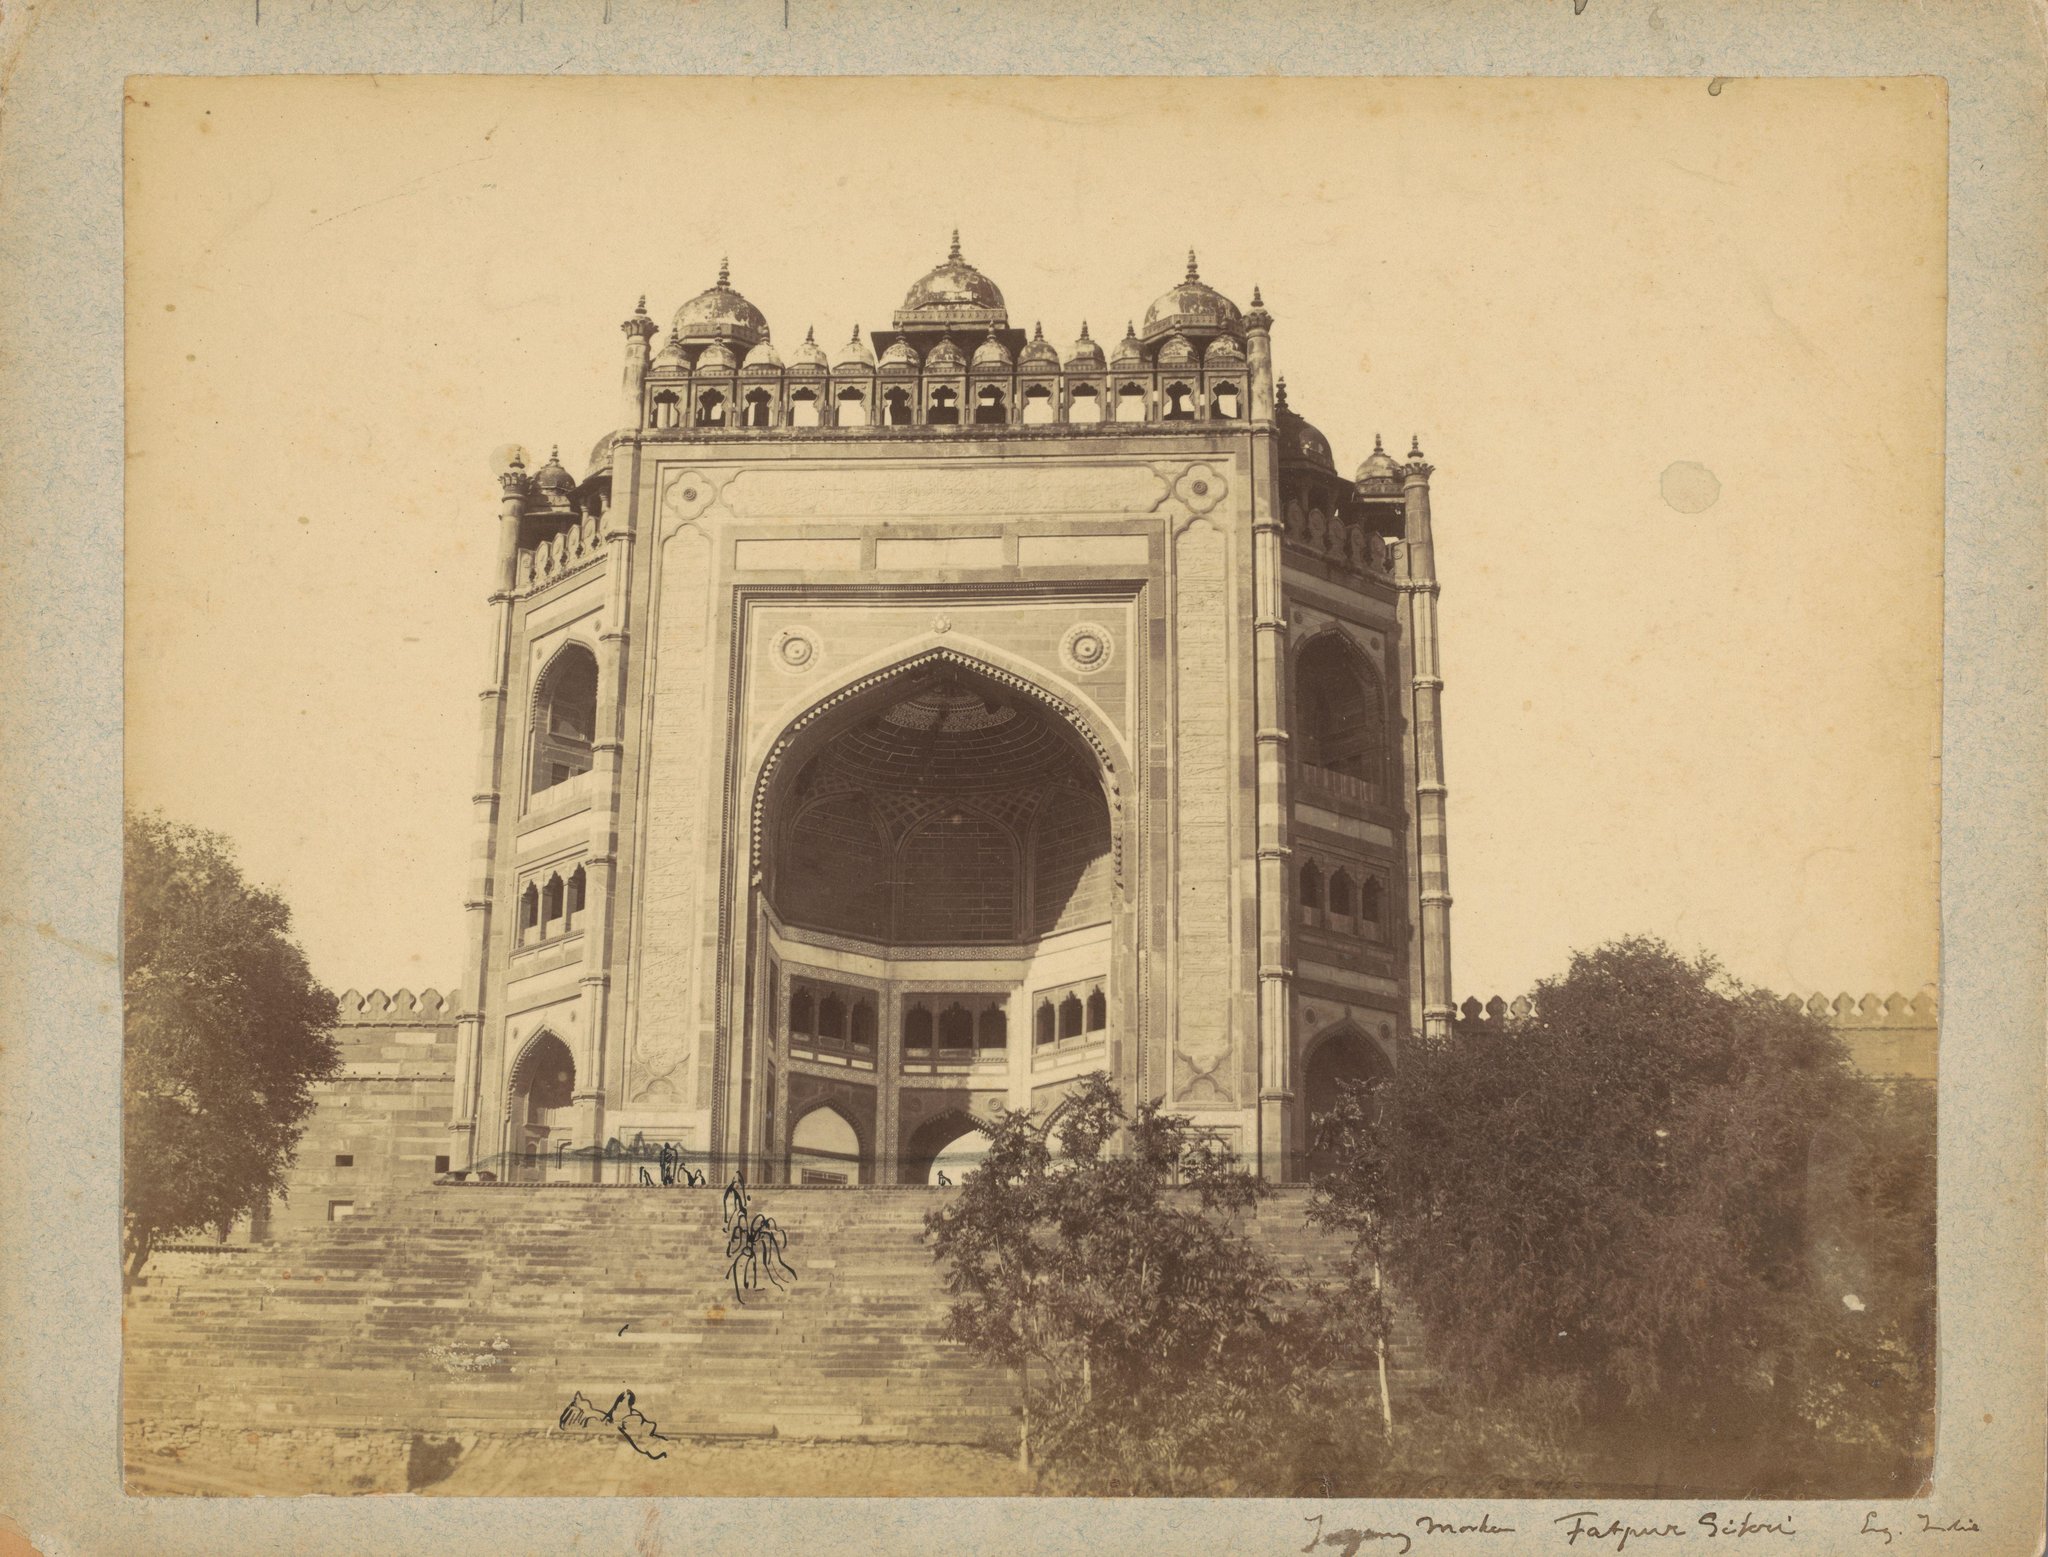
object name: photograph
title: Buland Darwaza, Fatehpur Sikri, Uttar Pradesh, India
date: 1870-1890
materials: cardboard, ink, pencil, photographic support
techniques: albumen print, pen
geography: fatehpur sikri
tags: temple, shrine ~ islam, mohammedanism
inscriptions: inscription: ‘Ingang Moskee Fatpur Sikri Eng. India’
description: Buland Darwaza is de toegangspoort tot het paleiscomplex te Fatehpur Sikri.